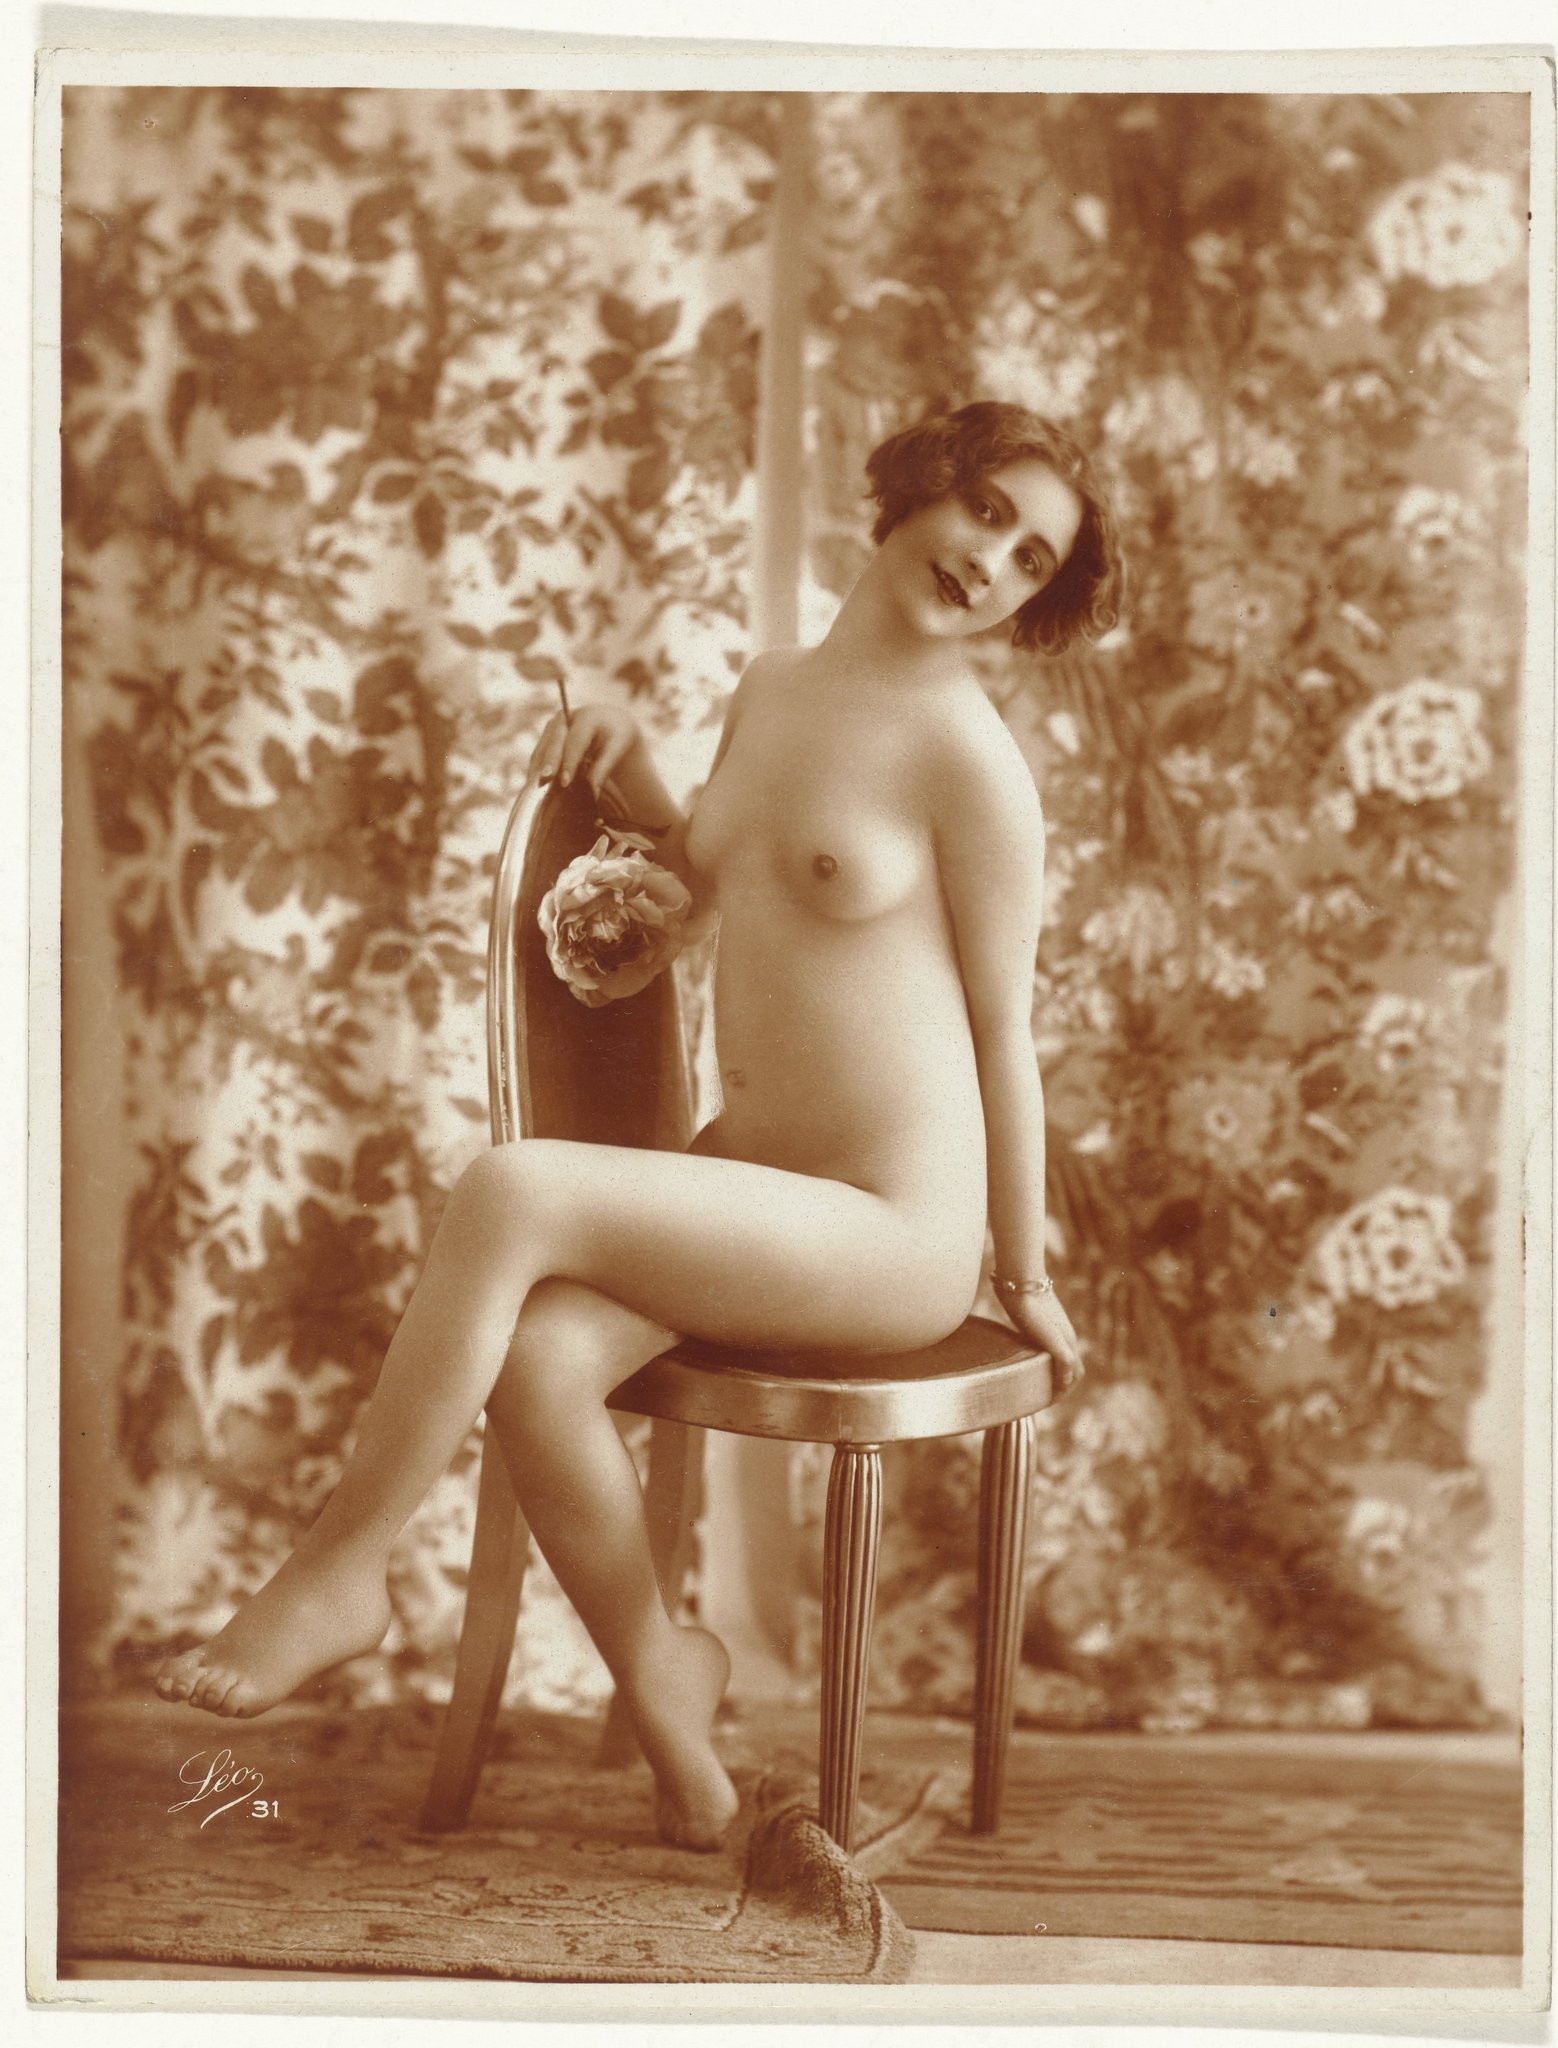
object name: photograph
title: Vrouwelijk naakt op stoel met bloem in haar hand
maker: léo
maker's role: fotograaf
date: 1900-1920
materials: paper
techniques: gelatin silver print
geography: france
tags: the (nude) human figure; 'corpo humano' (ripa) - aa - female human figure, france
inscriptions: number: ‘31’